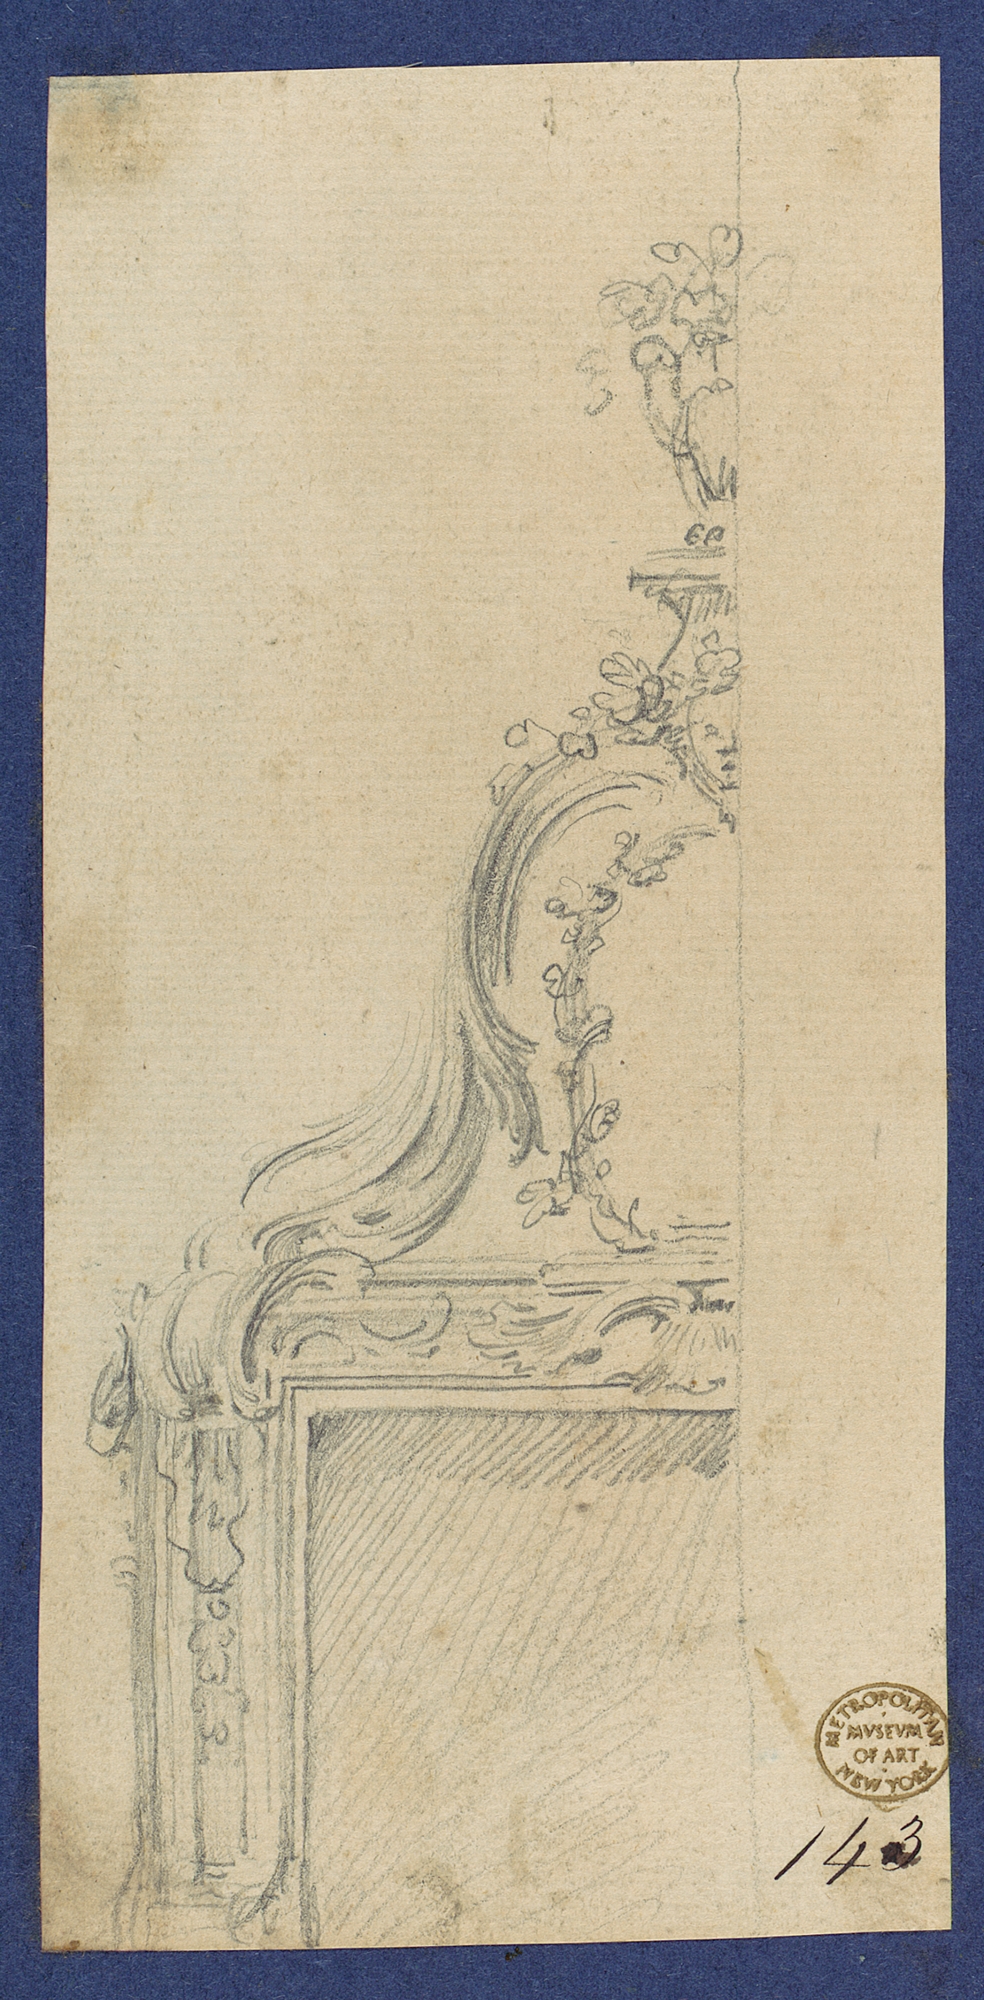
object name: drawing ornament architecture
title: Chimneypiece, in Chippendale Drawings, Vol. I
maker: thomas chippendale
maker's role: artist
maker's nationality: british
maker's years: 1718-1779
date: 1753-1762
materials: graphite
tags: fireplaces